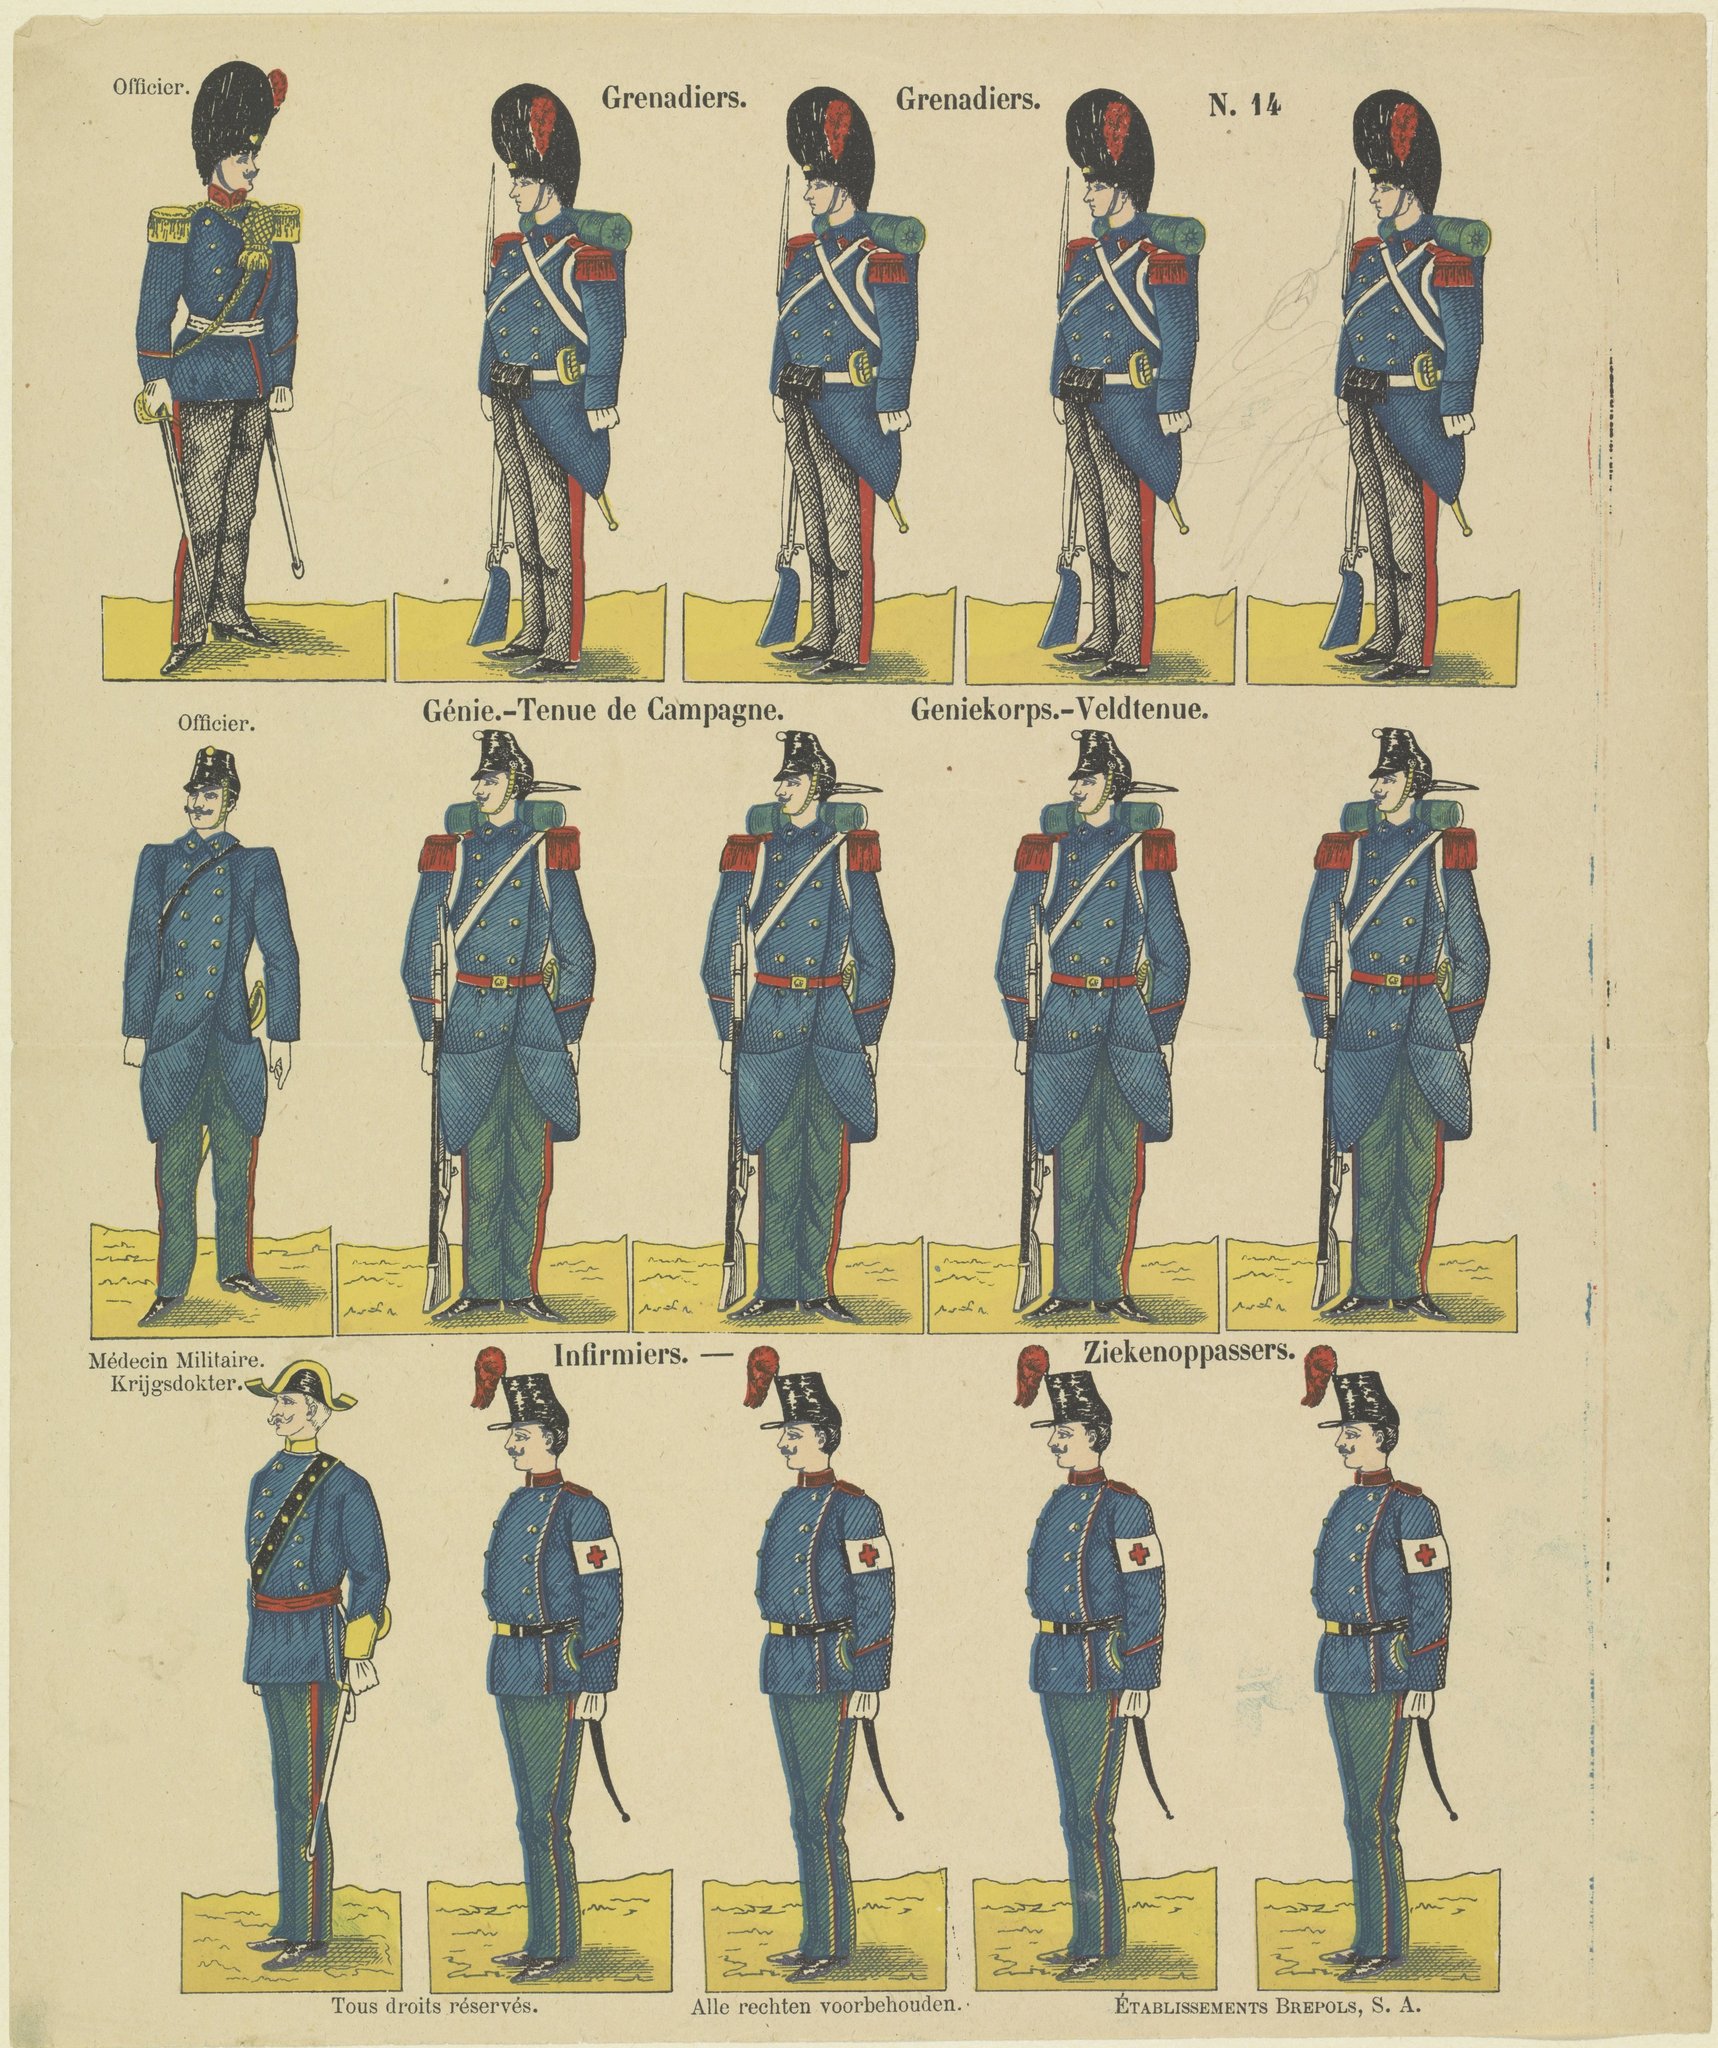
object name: print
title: Grenadiers / Grenadiers / Génie.-Tenue de Campagne / Geniekorps.-Veldtenue / Infirmiers / Ziekenoppassers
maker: Anonymous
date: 1911-1991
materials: paper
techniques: lithograph, letterpress printing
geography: turnhout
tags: physician, doctor, the soldier; the soldier's life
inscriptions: octrooivermelding, gedrukt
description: Blad met 3 horizontale rijen met in totaal 15 voorstellingen van officieren, militairen met geweren, een krijgsdokter en ziekenoppassers. Genummerd rechtsboven: N. 14.